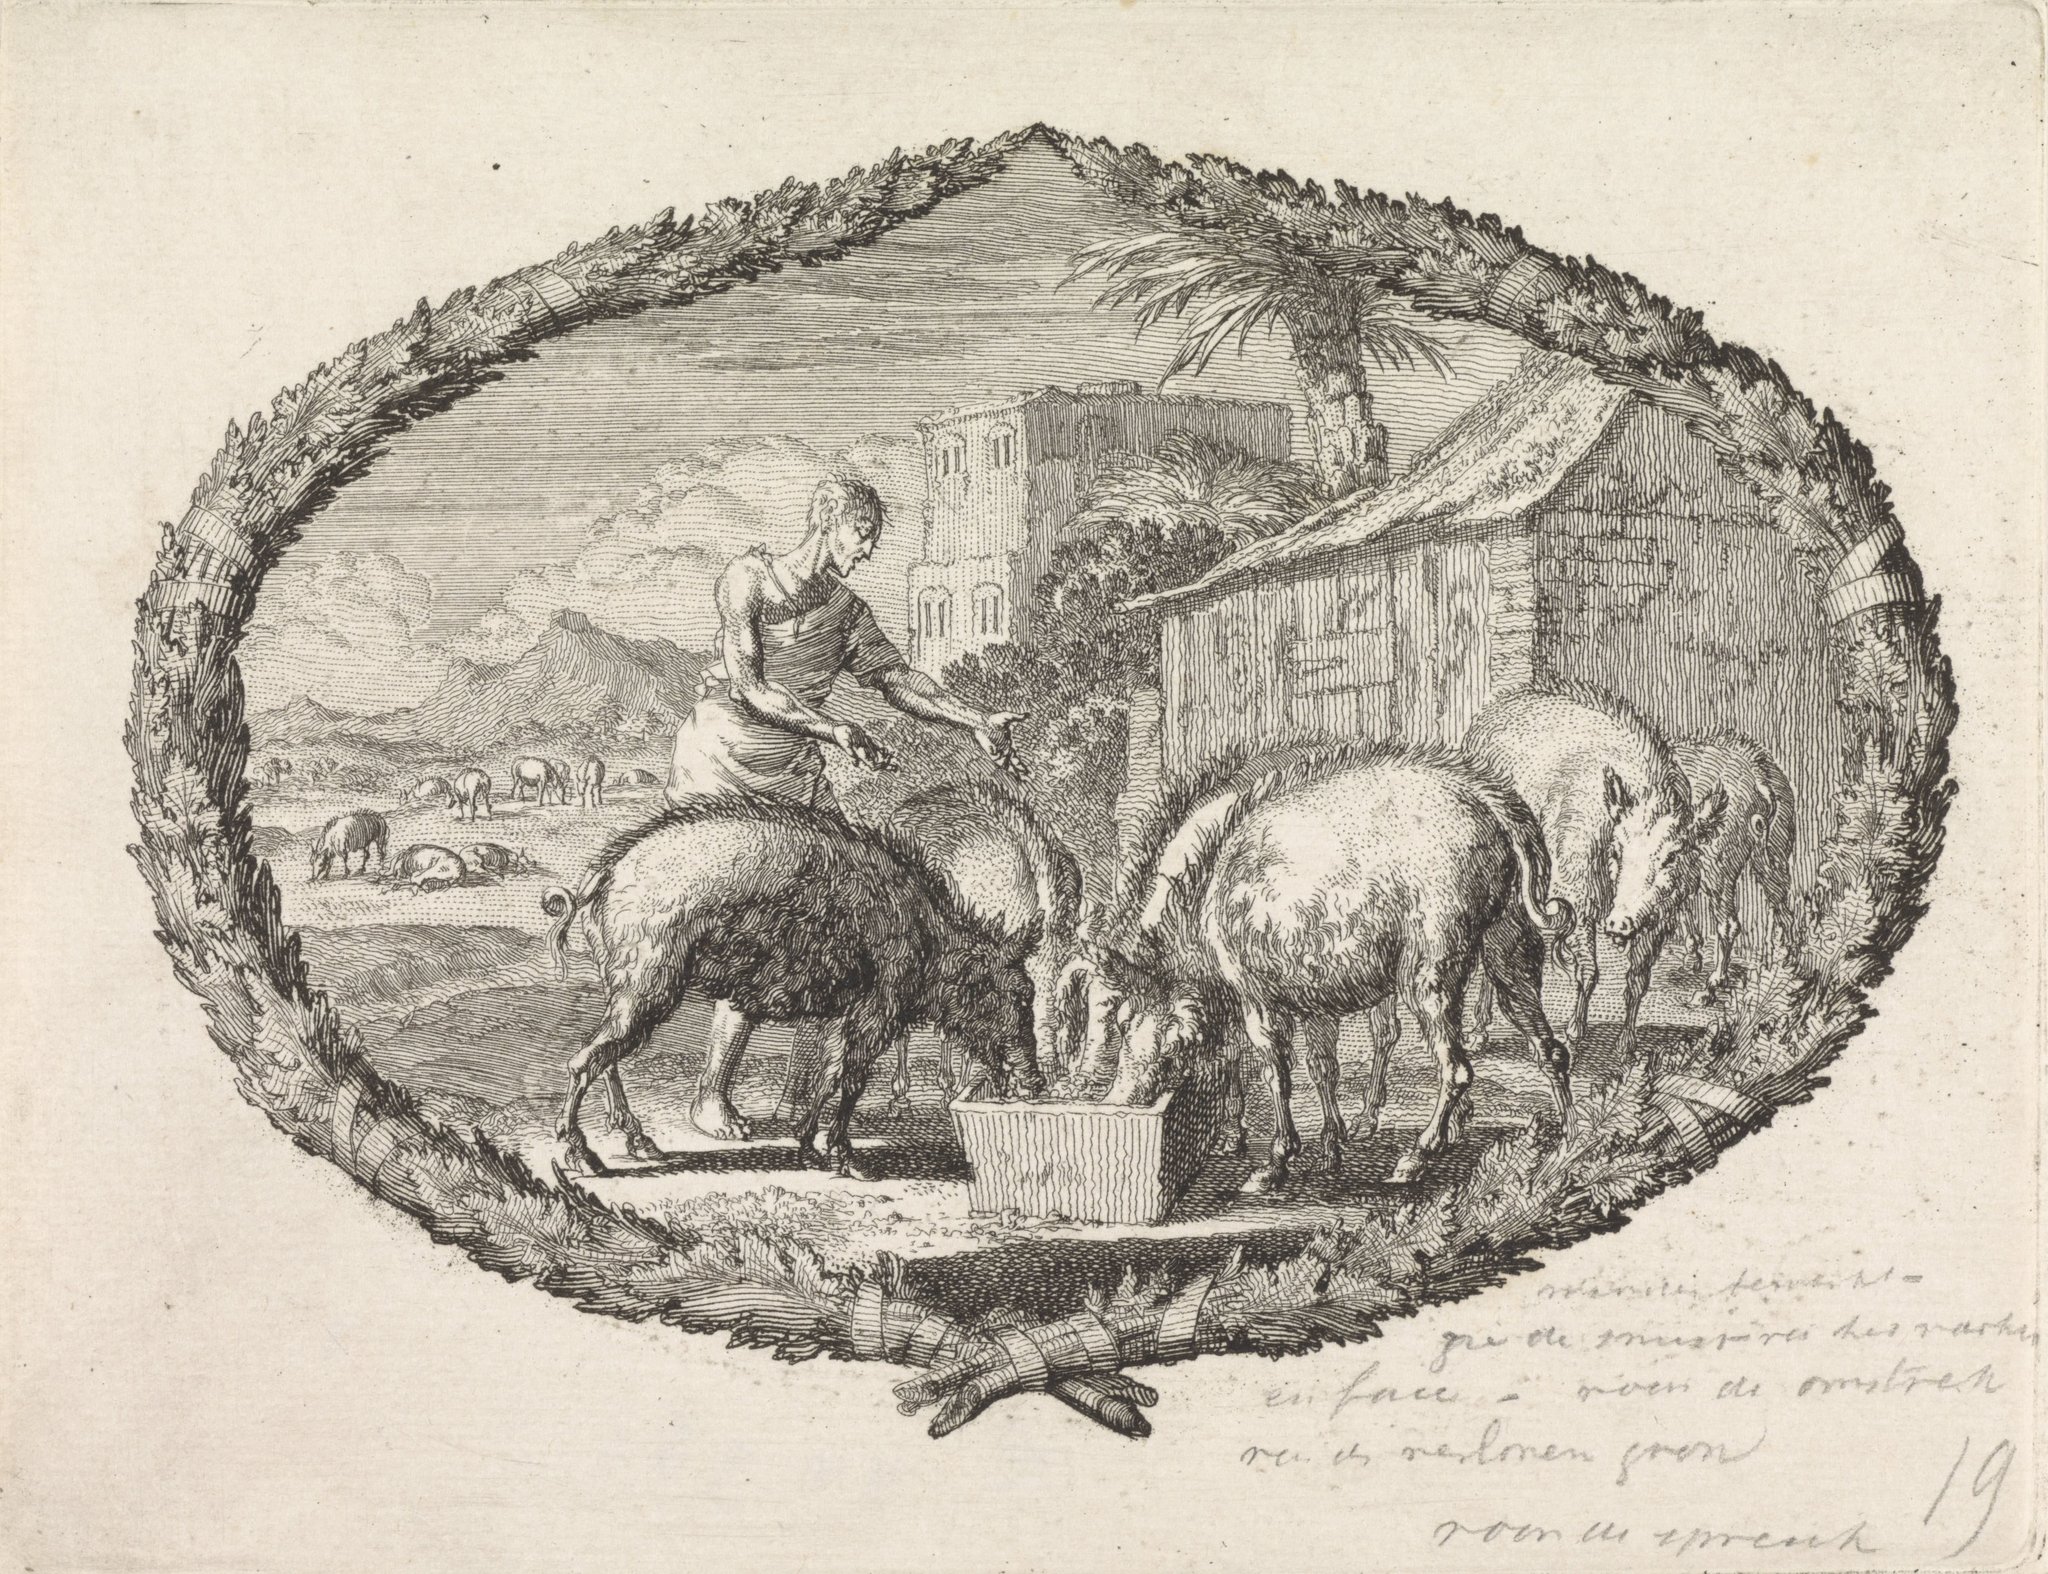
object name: print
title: De verloren zoon als varkenshoeder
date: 1700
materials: paper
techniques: etching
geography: amsterdam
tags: ornament ~ cartouche, the prodigal son tends the swine and eats from their trough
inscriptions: collector's mark: Lugt 2228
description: Proefdruk van een boekillustratie voor David Martin. Historie des Ouden en Nieuwen Testaments, verrykt met meer dan vierhonderd printverbeeldingen. Deel II. Amsterdam: Pieter Mortier, 1700.